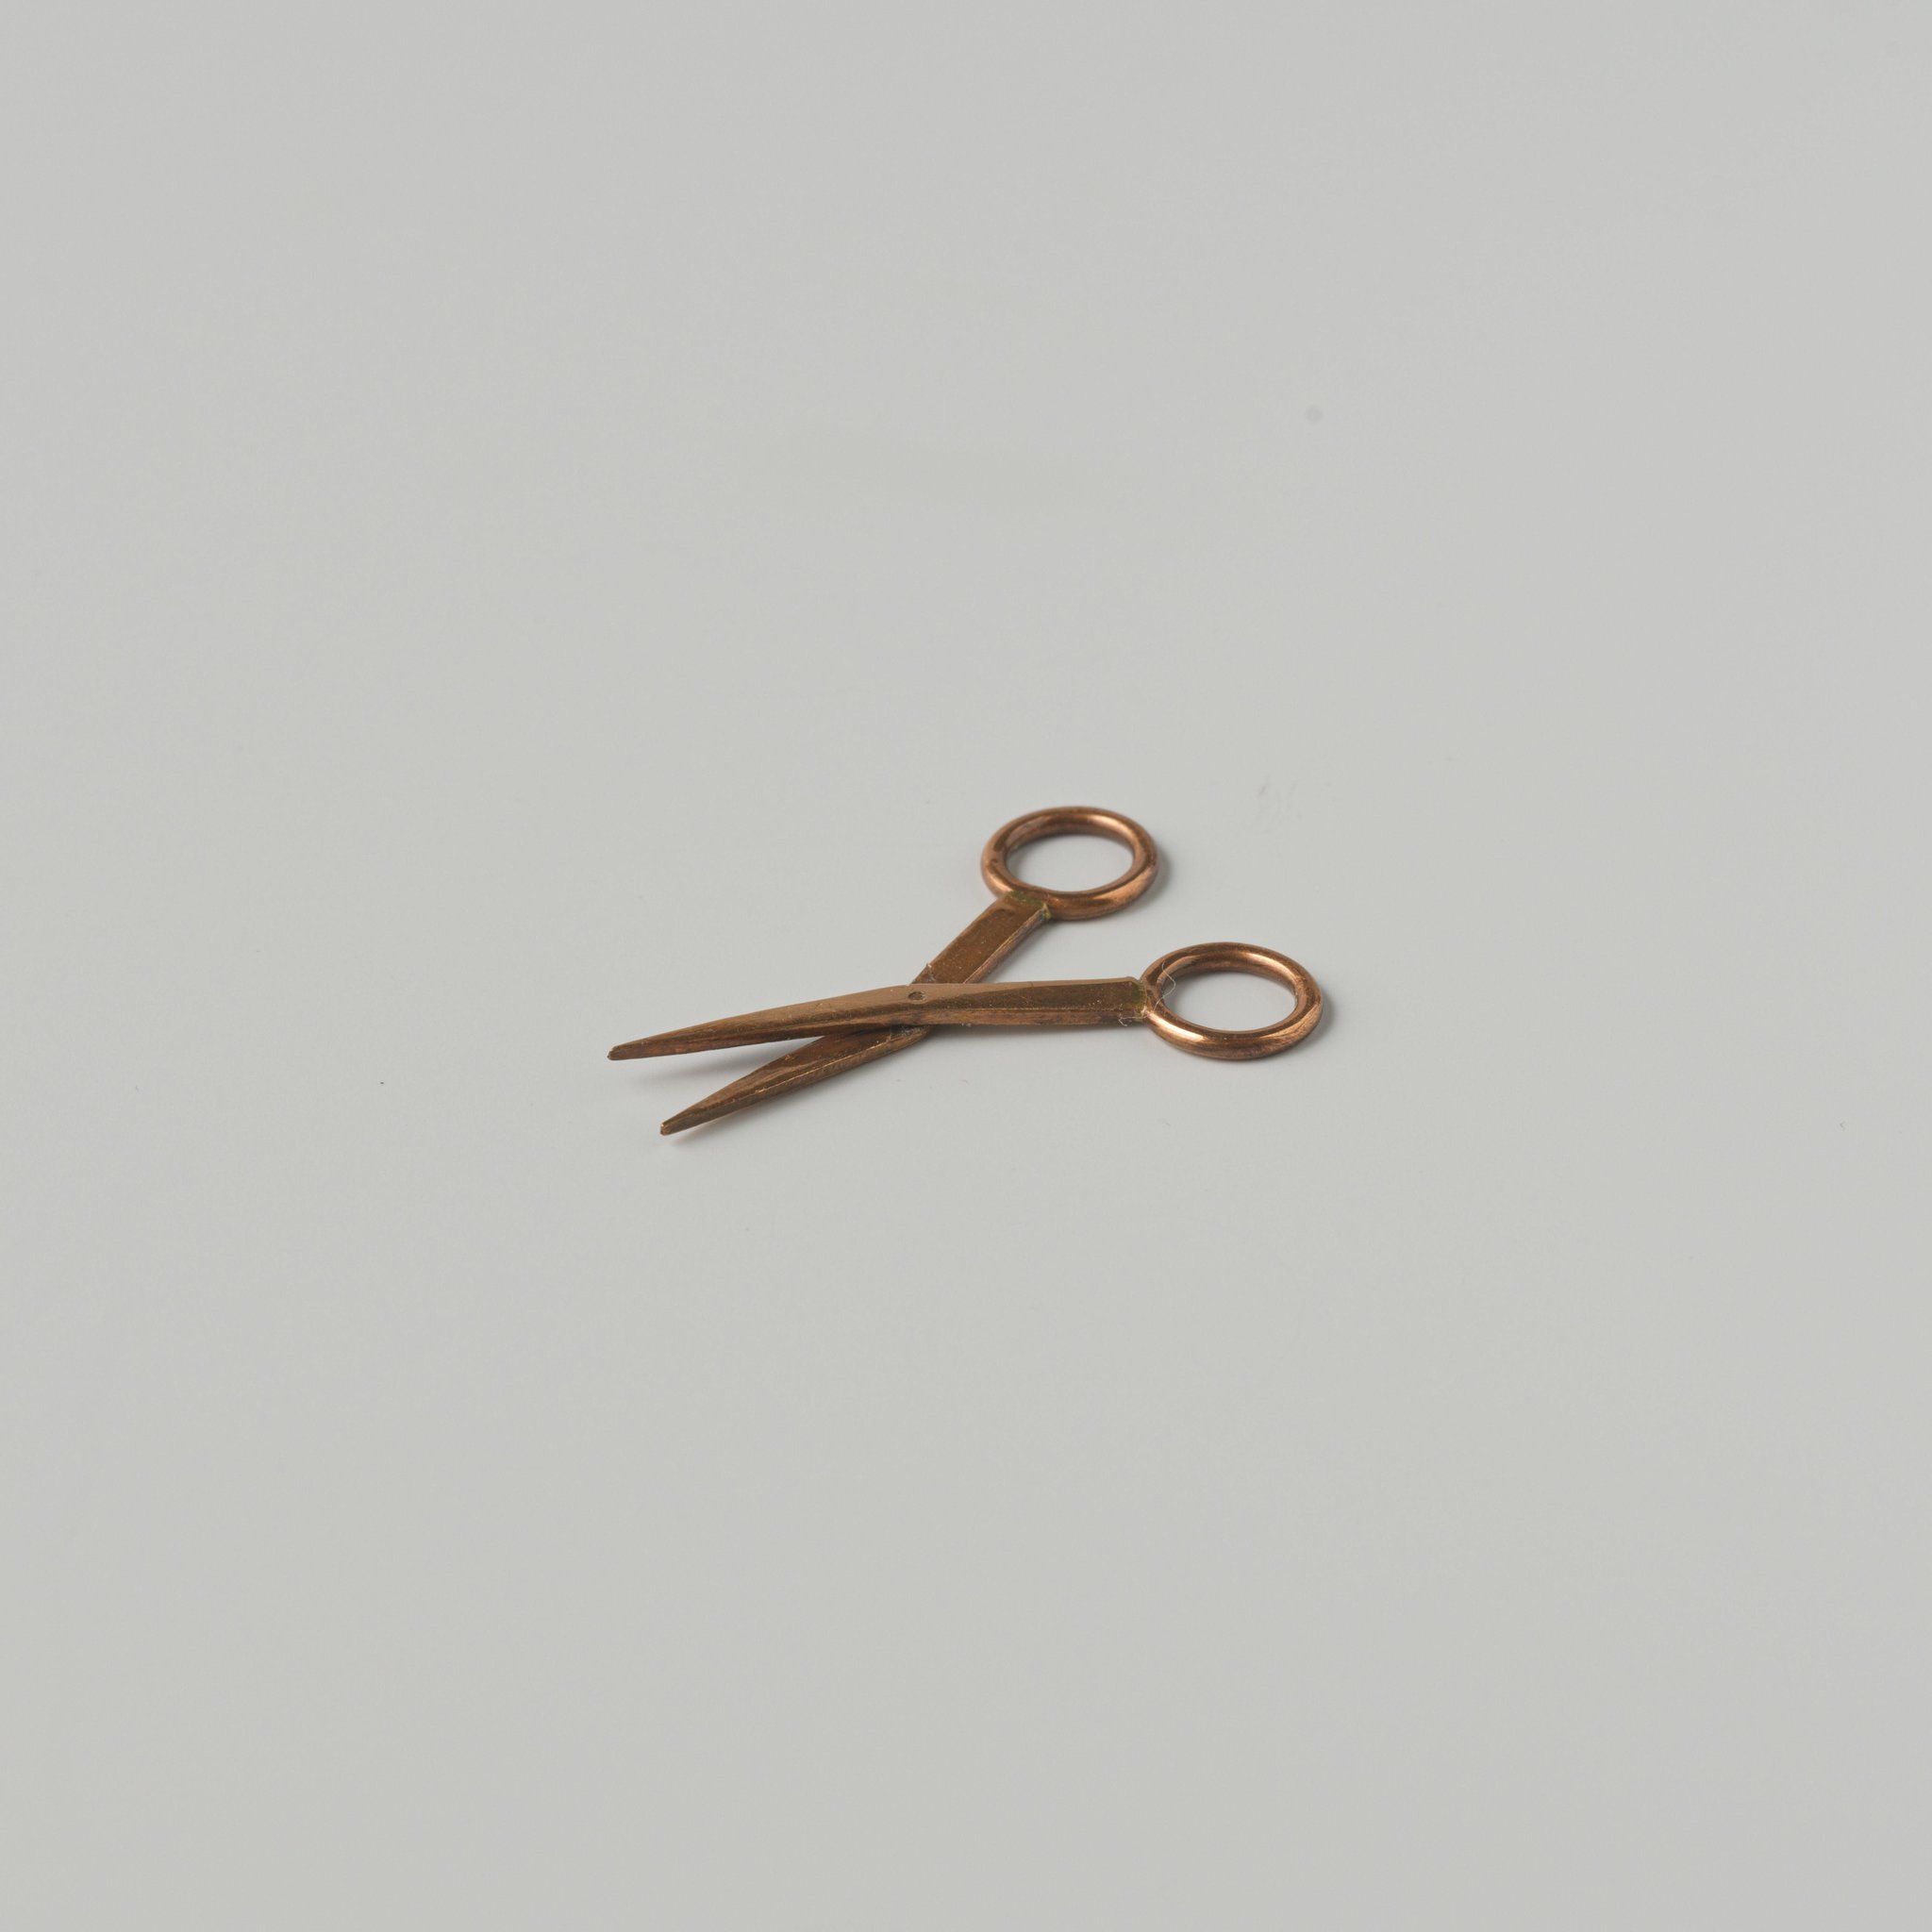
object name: scissors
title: Schaar van roodkoper met ringvormige grepen, en scharnierend om een klink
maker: Anonymous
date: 1690-1710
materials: copper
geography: amsterdam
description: Schaar van roodkoper met ringvormige grepen, en scharnierend om een klink.